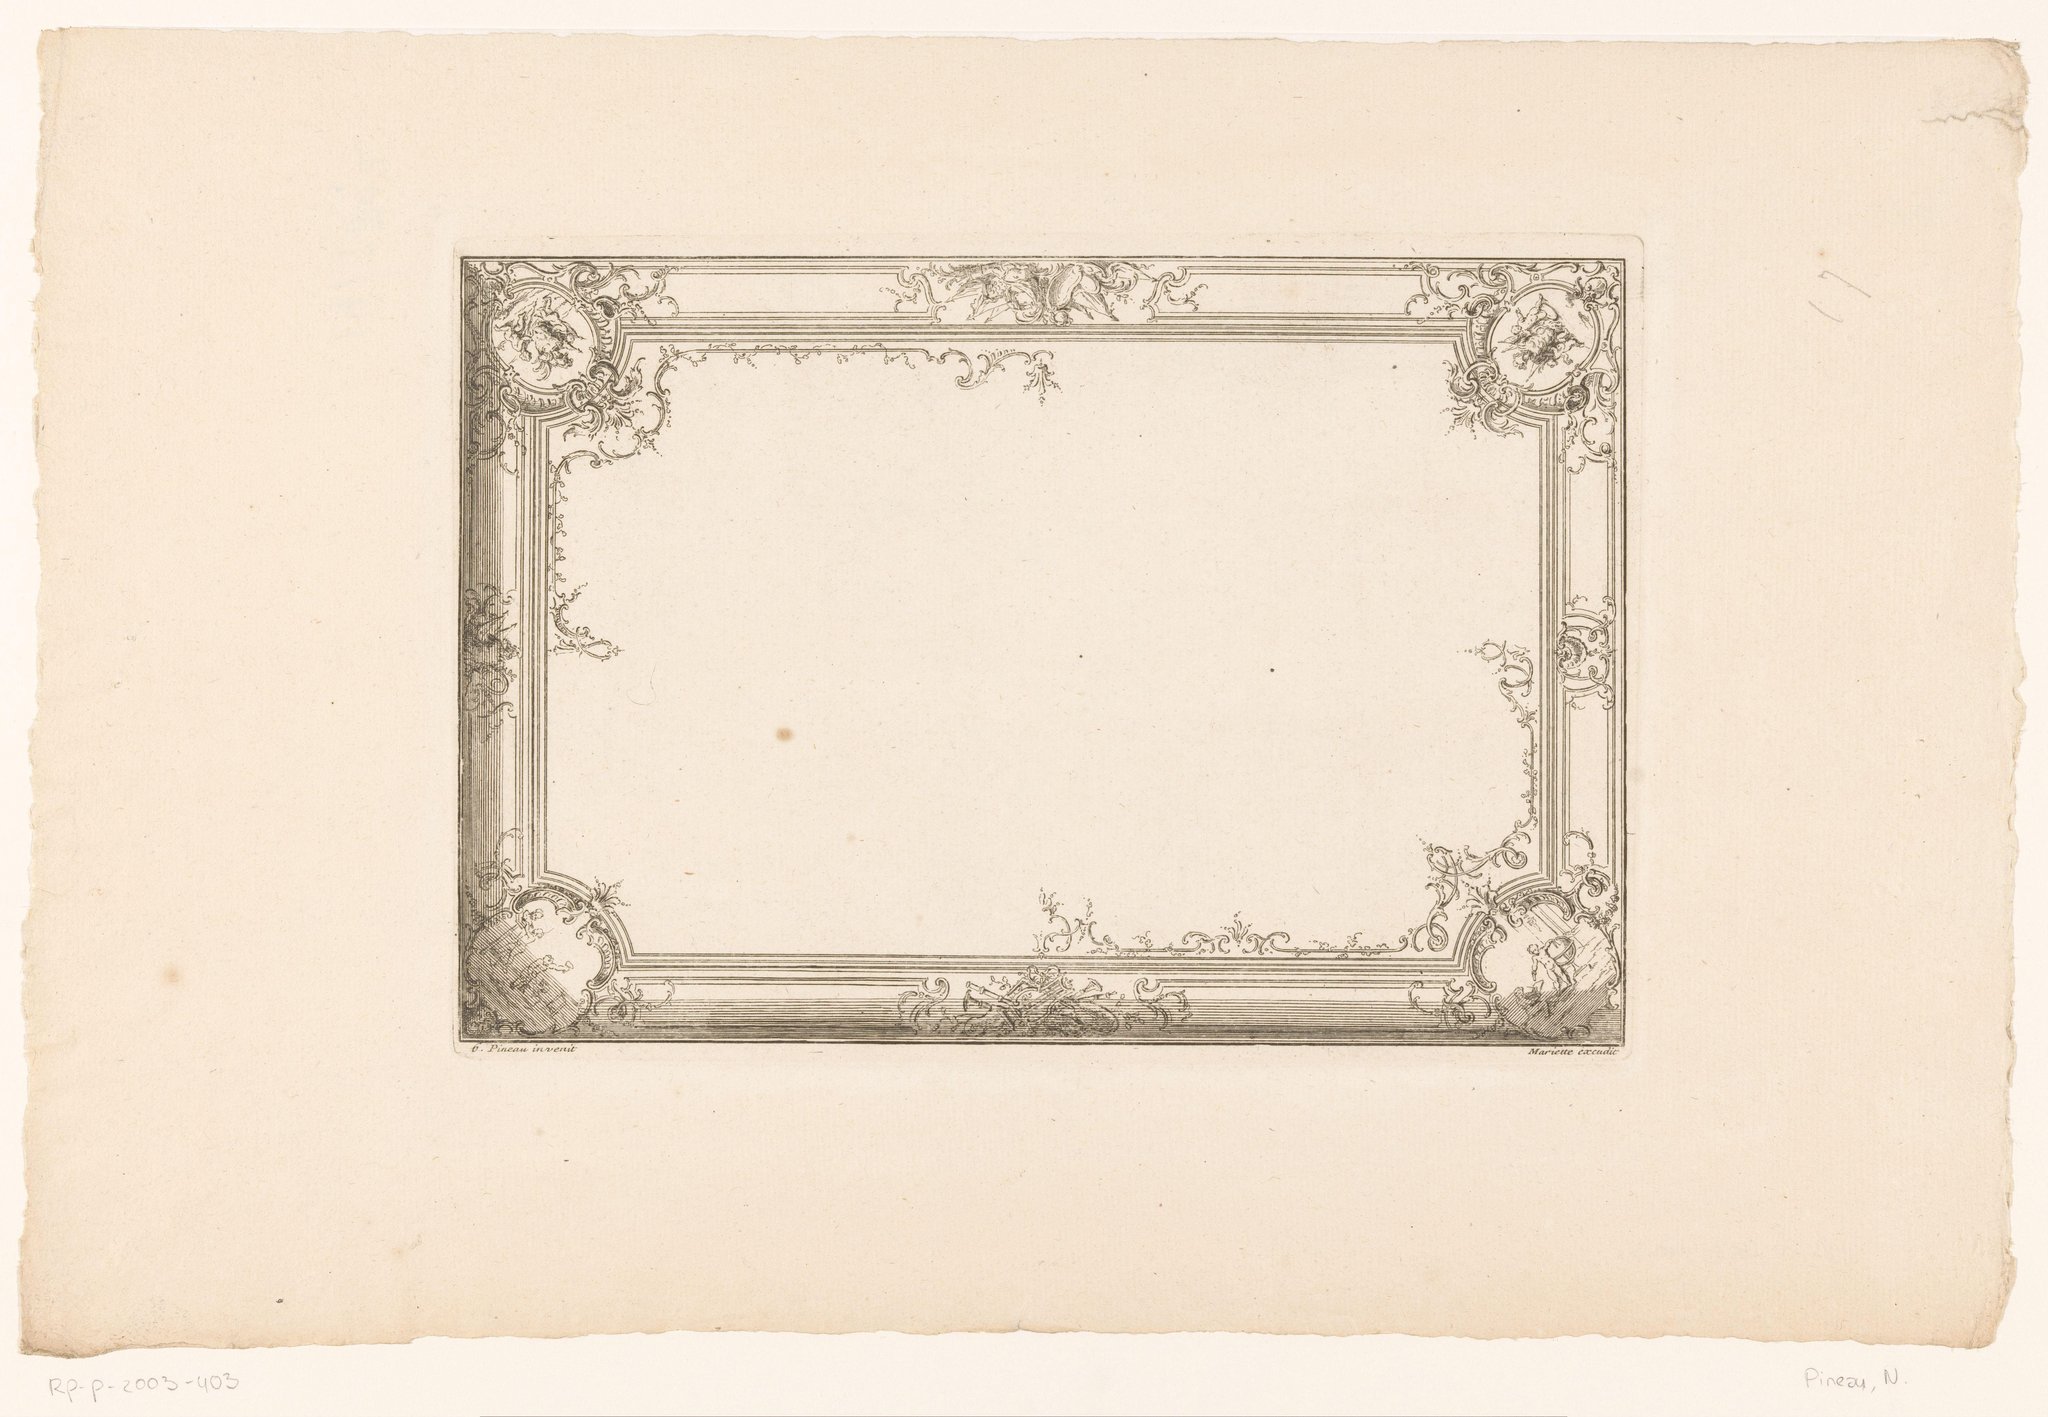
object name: ornament print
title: Nouveaux desseins de Plafonds inventés par Pineau et qui peuvent s'executer en sculture ou en peinture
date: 1725-1735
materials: paper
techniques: etching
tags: trophy, i.e.: decorative arrangement of symbolic or typical objects ~ ornament, (decorated) ceiling, classical mythology and ancient history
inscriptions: collector's mark: Lugt 2760, collector's mark: Lugt 2228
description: Ontwerp voor een rechthoekig plafond met in de hoeken cartouches met mythologische voorstellingen en putti met wapentrofeeën.